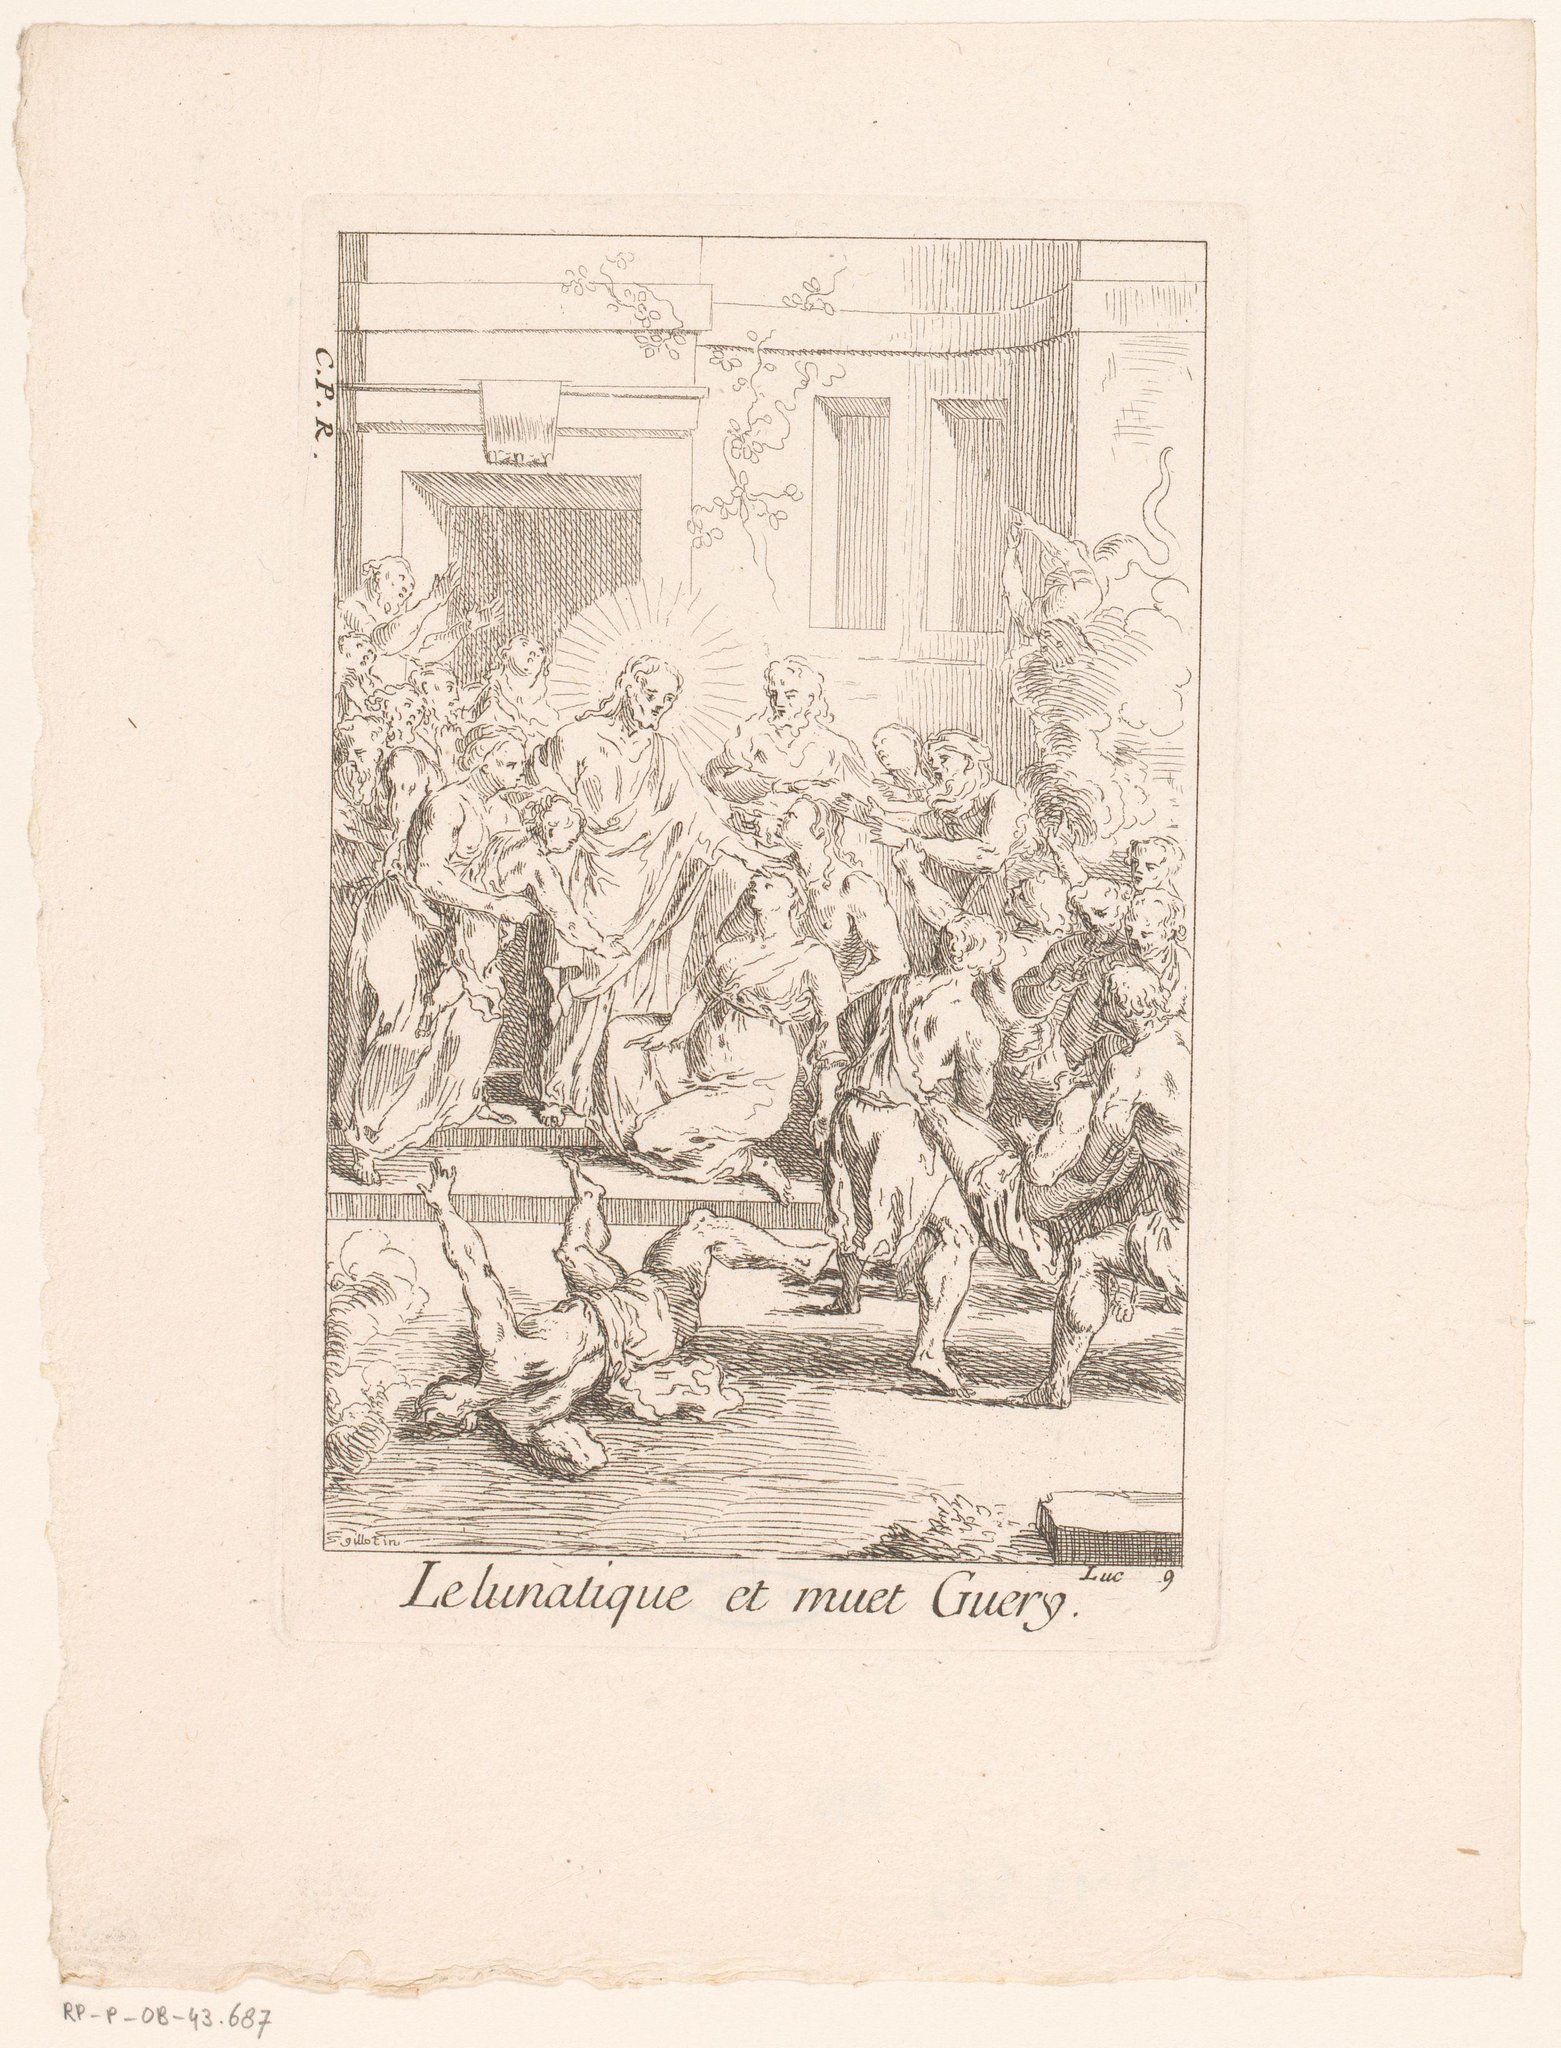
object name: print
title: Le lunatique et muet Guery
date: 1705-1732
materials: paper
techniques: etching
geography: paris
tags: christ healing possessed people, healing of a possessed man who could not speak (matthew 9:32-34; luke 11:14-16)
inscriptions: collector's mark: Lugt 2228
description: De voorstelling is gebaseerd op Matteüs 9:32-34 en Lucas 11:14-16 . In de Statenvertaling staat het als volgt beschreven: “Als dezen nu uitgingen, ziet, zo brachten zij tot Hem een mens, die stom en van den duivel bezeten was. En als de duivel uitgeworpen was, sprak de stomme.” In de Nieuwe Bijbelvertaling 21 staat: “Terwijl ze het huis weer verlieten, bracht men iemand bij Hem die bezeten was en niet kon spreken. Nadat de demon was uitgedreven, begon de stomme te spreken.”